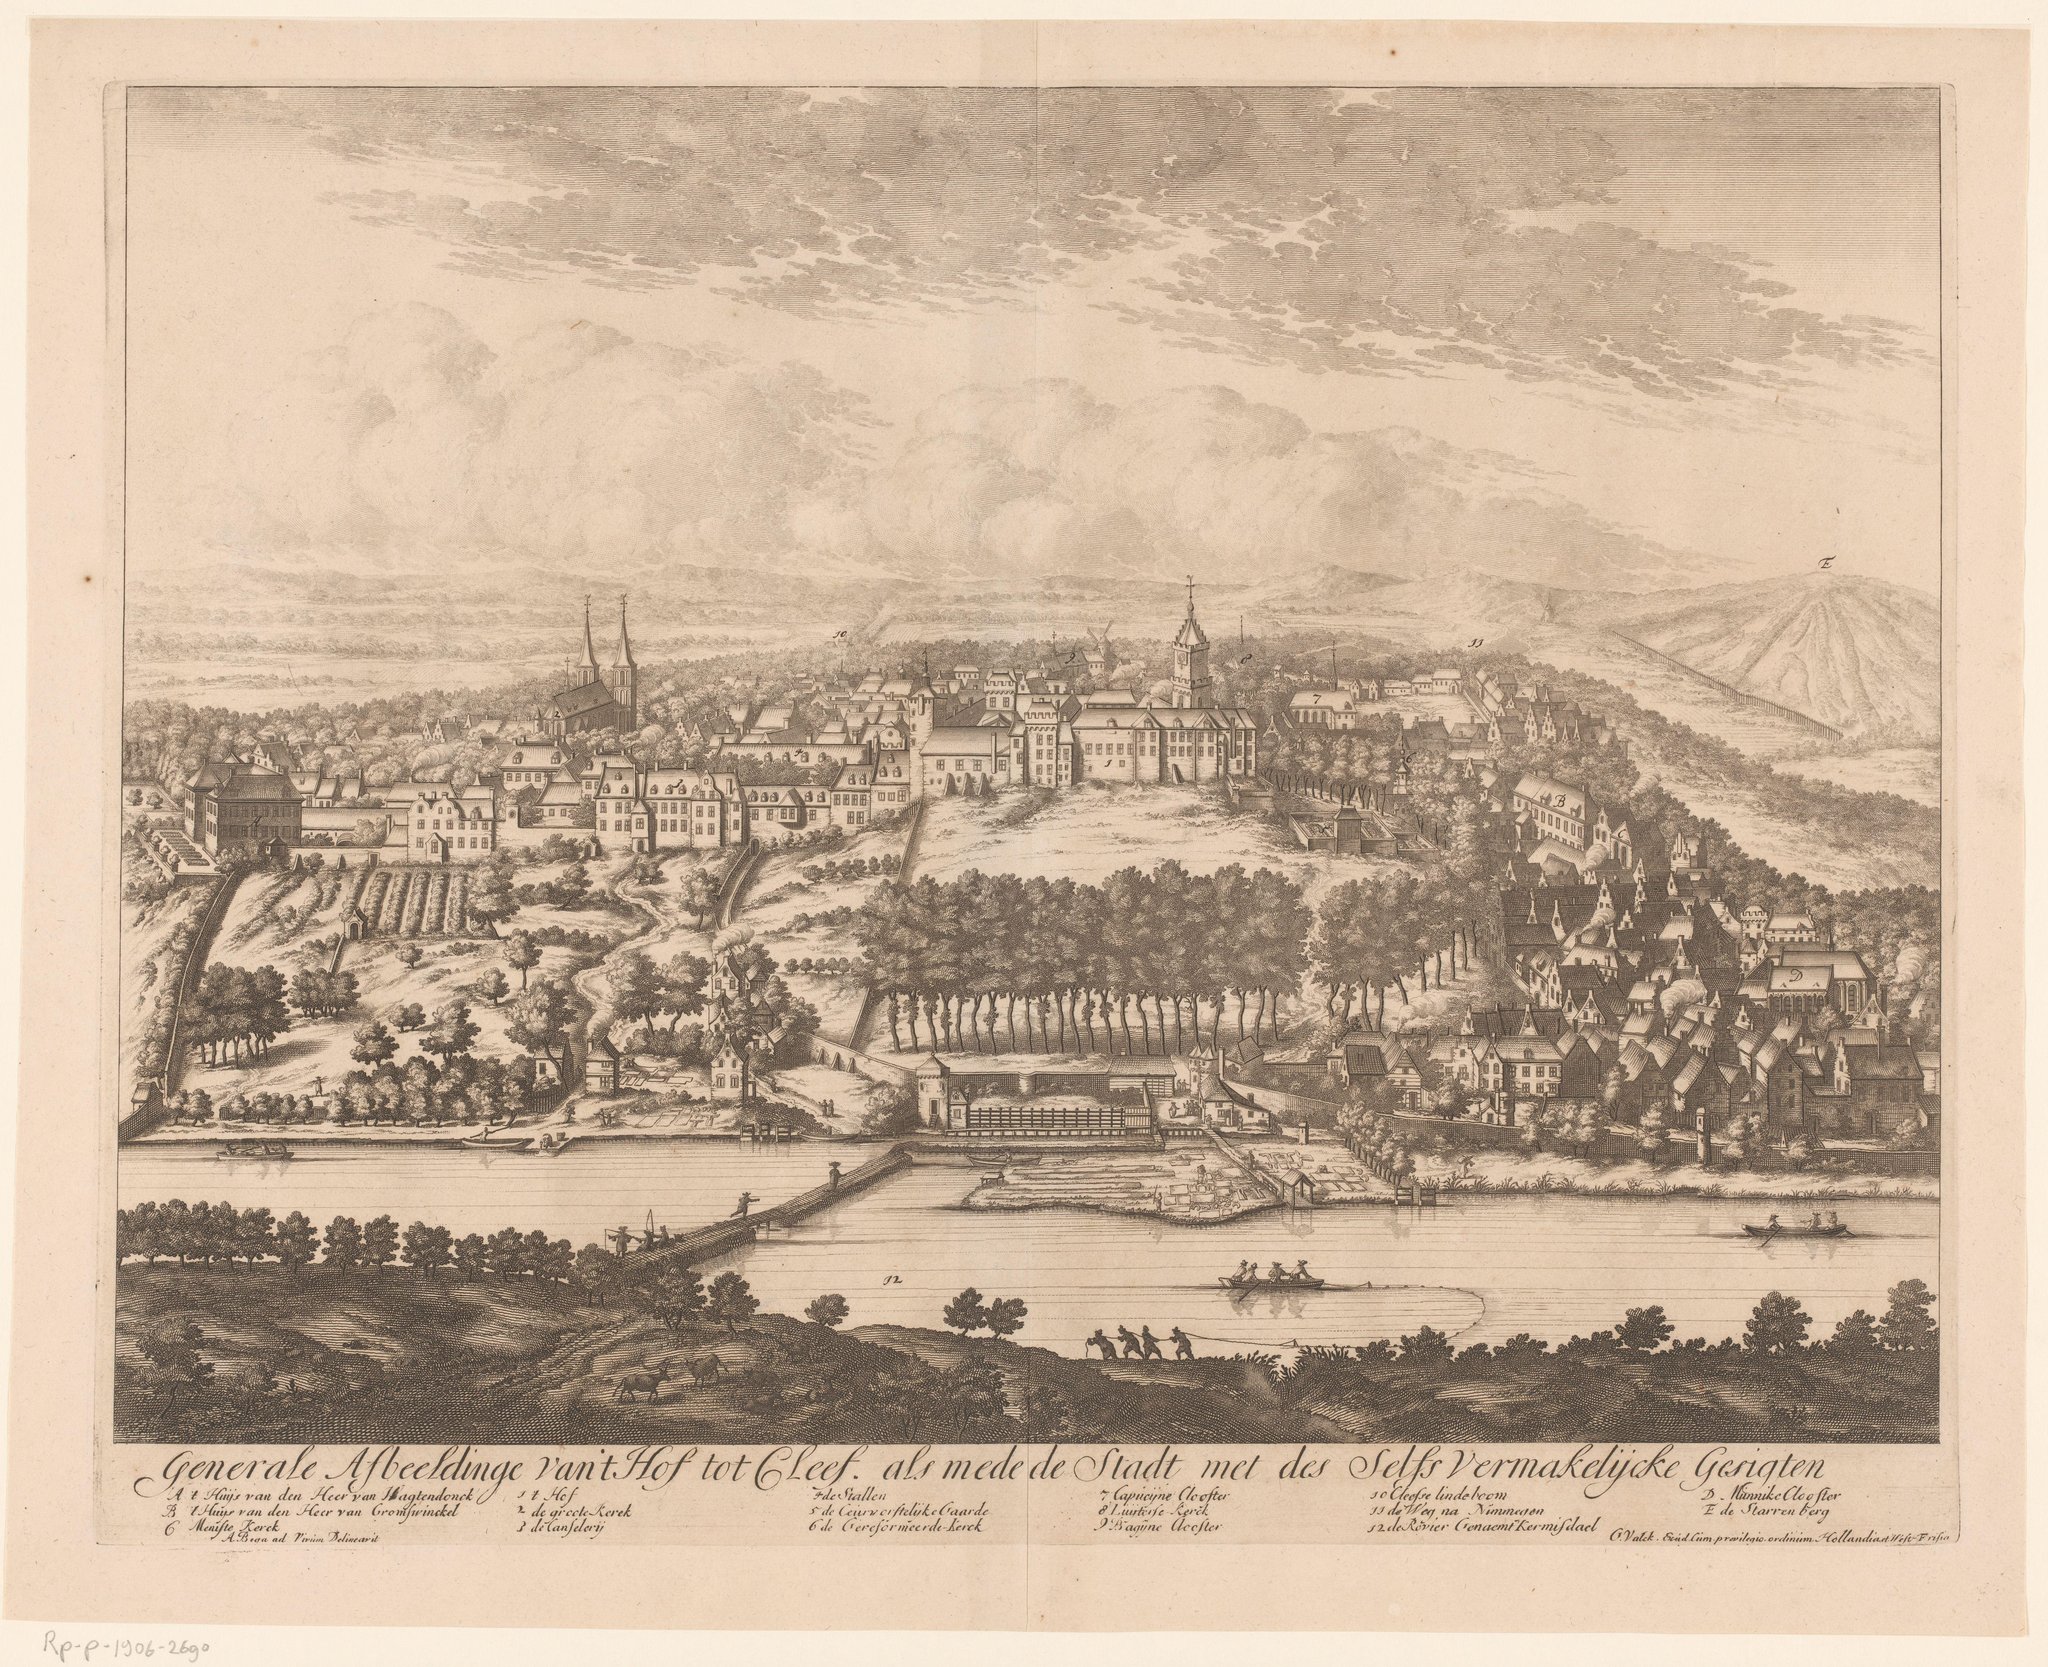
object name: print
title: Generale afbeeldinge van 't Hof tot Cleef. Als mede de stadt met des selfs vermakelijcke gesigten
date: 1695-1726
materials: paper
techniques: engraving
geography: amsterdam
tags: prospect of city, town panorama, silhouette of city, cleves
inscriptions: collector's mark: Lugt 2228